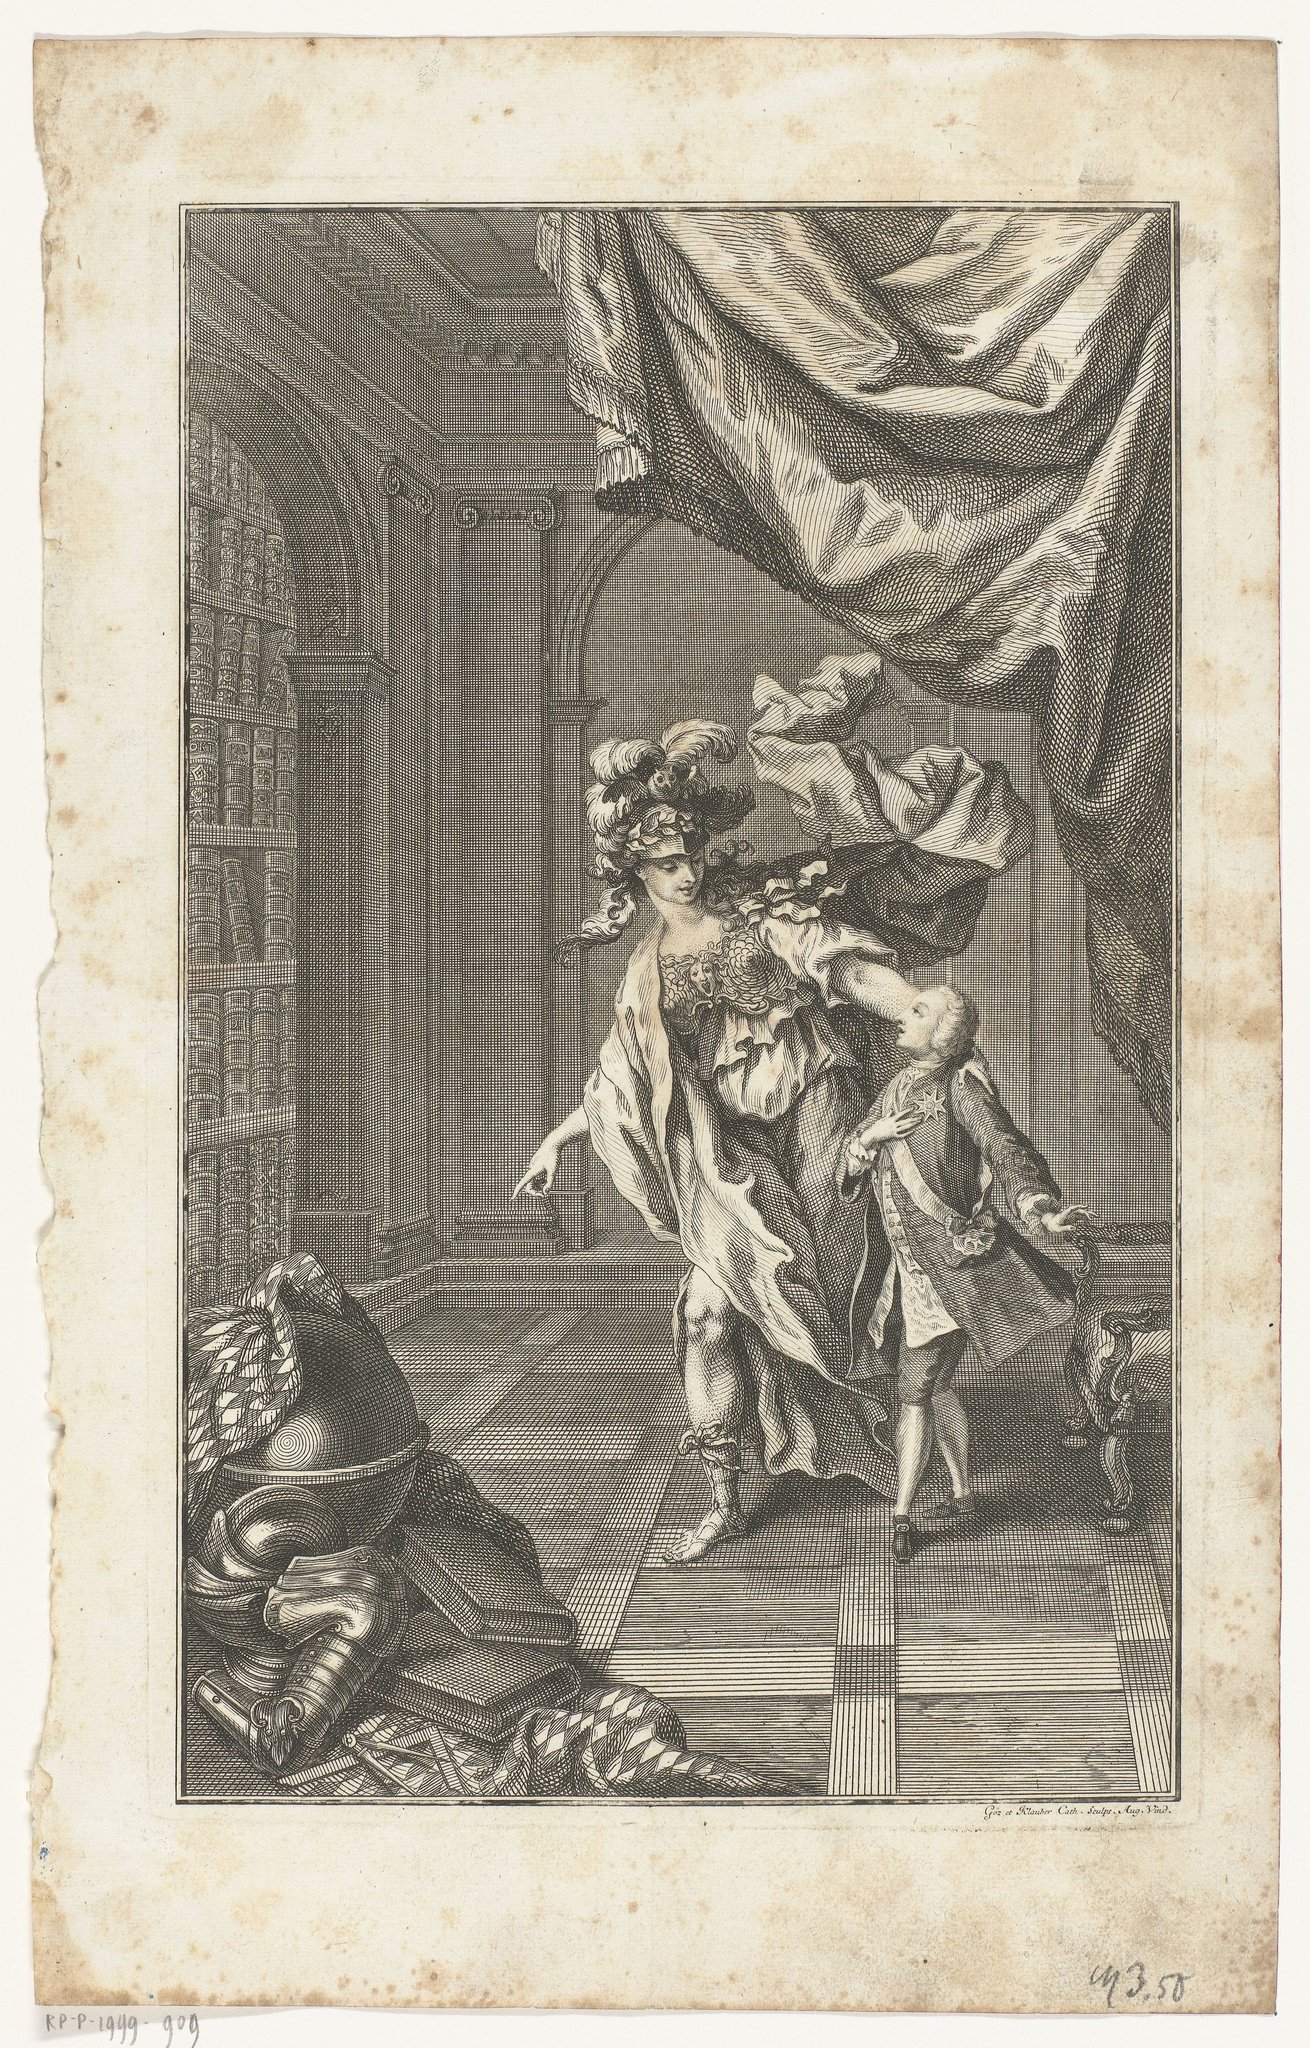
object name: print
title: Maximiliaan III Jozef van Beieren begeleid door Minerva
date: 1737-1774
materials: paper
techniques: engraving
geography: augsburg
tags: bookshelves, armour, historical persons, knowledge; 'cognitione', 'cognitione delle cose' (ripa), measuring-instruments, specific aspects, allegorical aspects of minerva; minerva as patroness, globe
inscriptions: collector's mark: Lugt 2228, collector's mark: Lugt 2760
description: Op de achterzijde van de prent is een lichte impressie te zien van een onleesbare titelpagina.